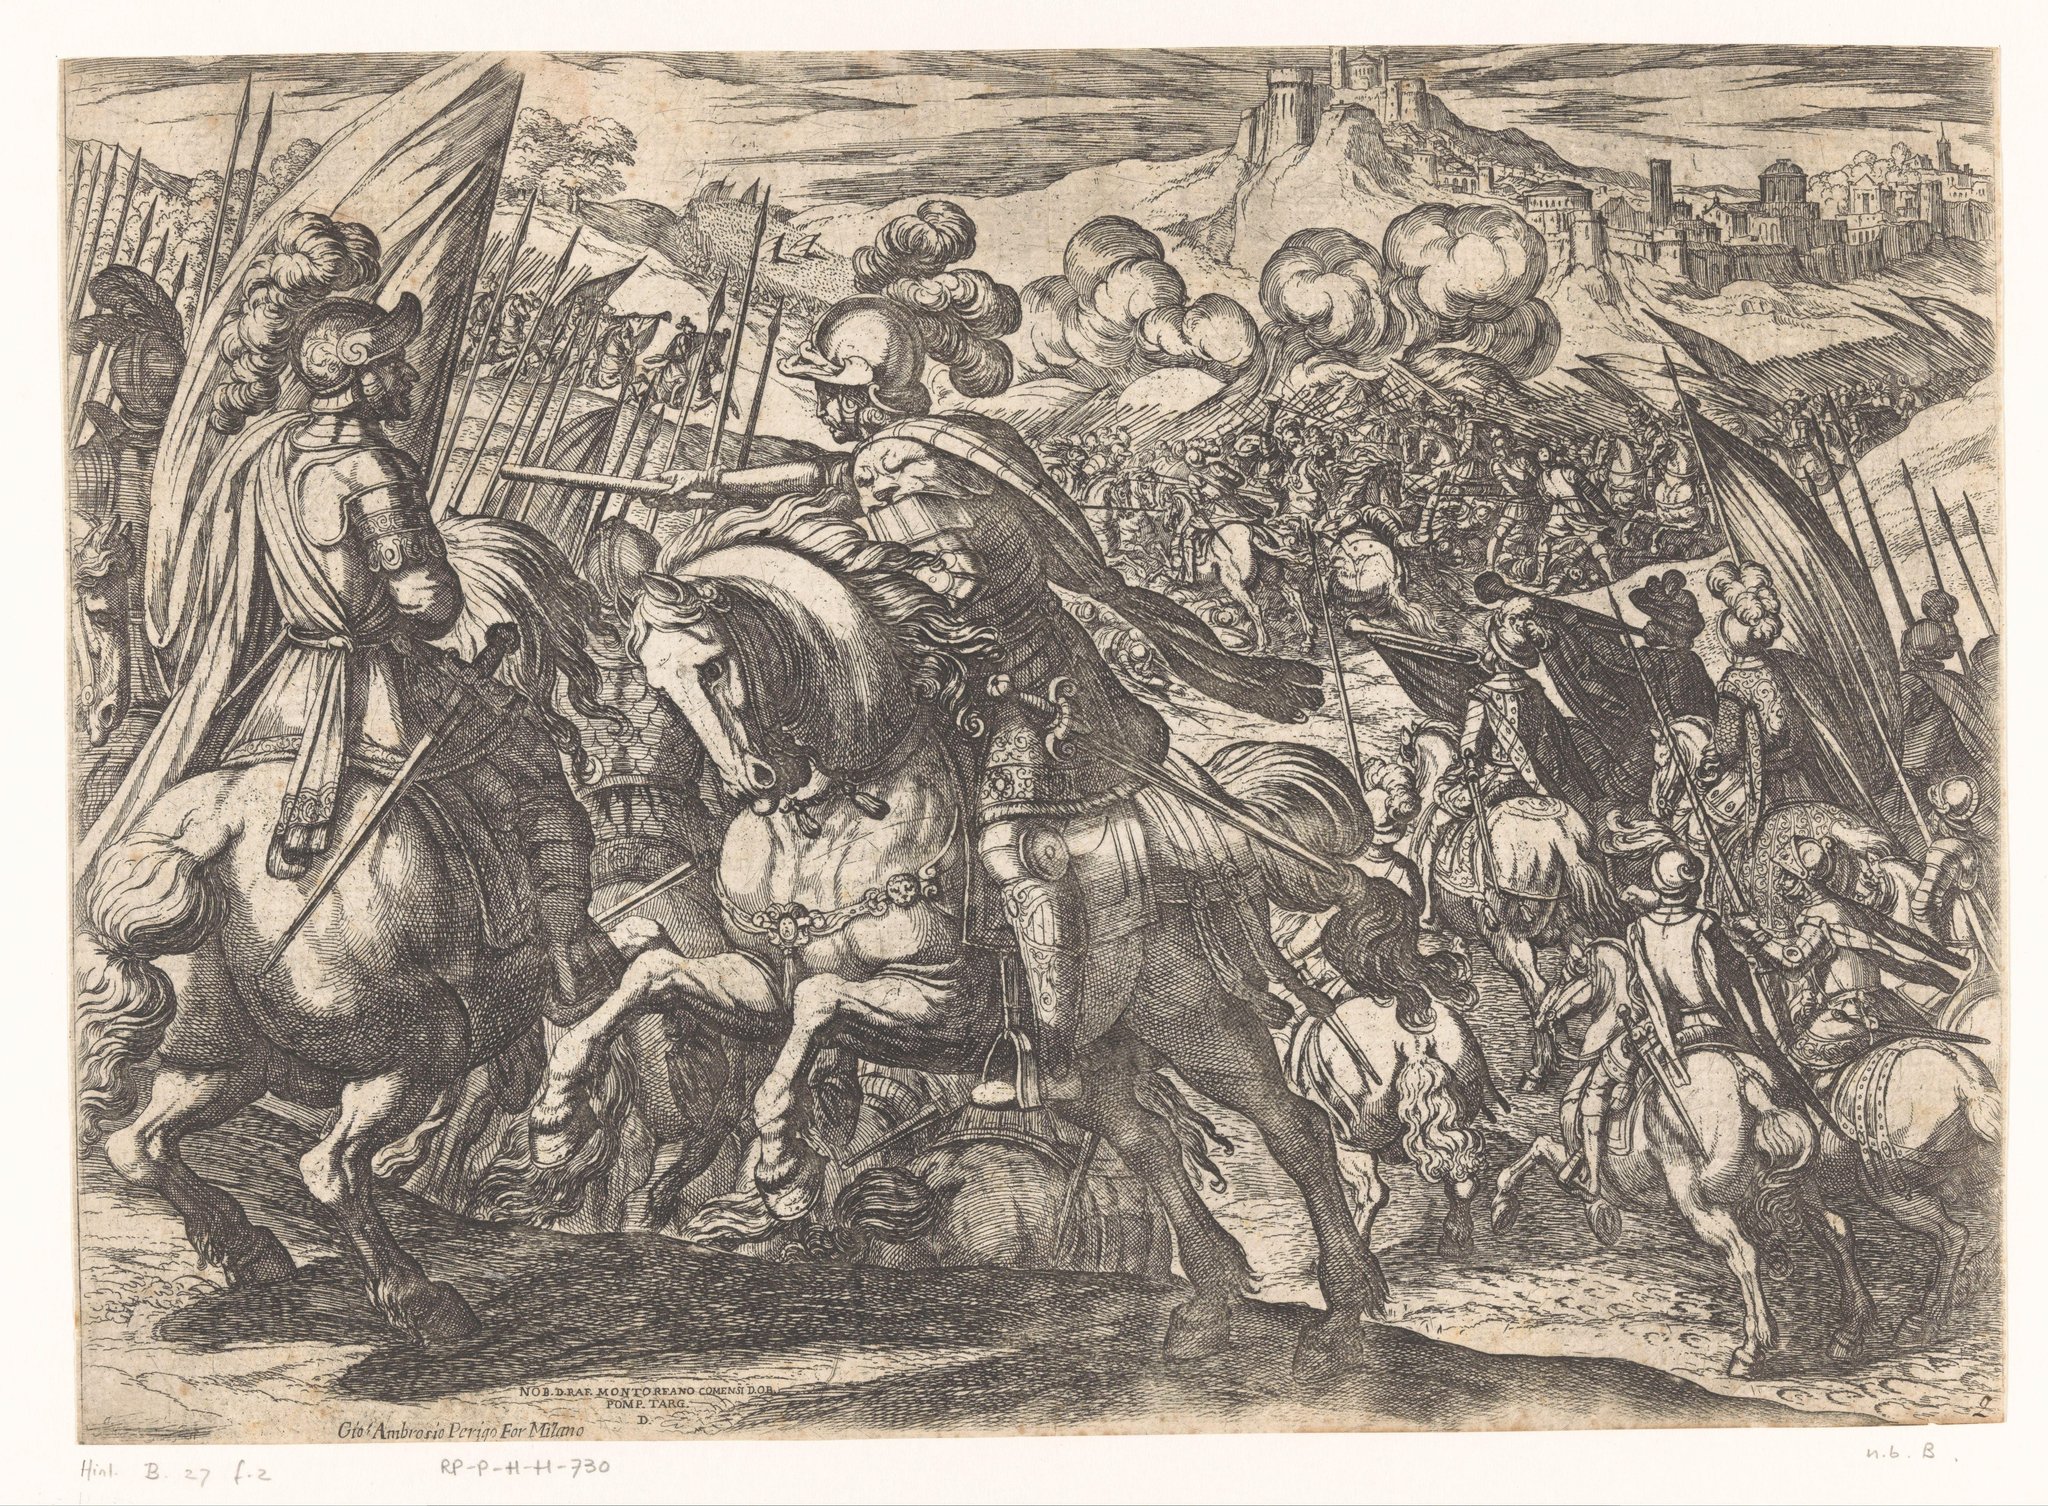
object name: print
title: Strijdgewoel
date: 1565-1630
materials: paper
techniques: etching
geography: italy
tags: battle, warfare; military affairs (+ cavalry, horsemen), the soldier; the soldier's life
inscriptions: collector's mark: Lugt 11, collector's mark: ‘Hinloopen’, number: ‘2’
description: Een landschap met een stad op een heuvel. In het dal op de voorgrond vindt een hevige strijd plaats tussen twee legers.